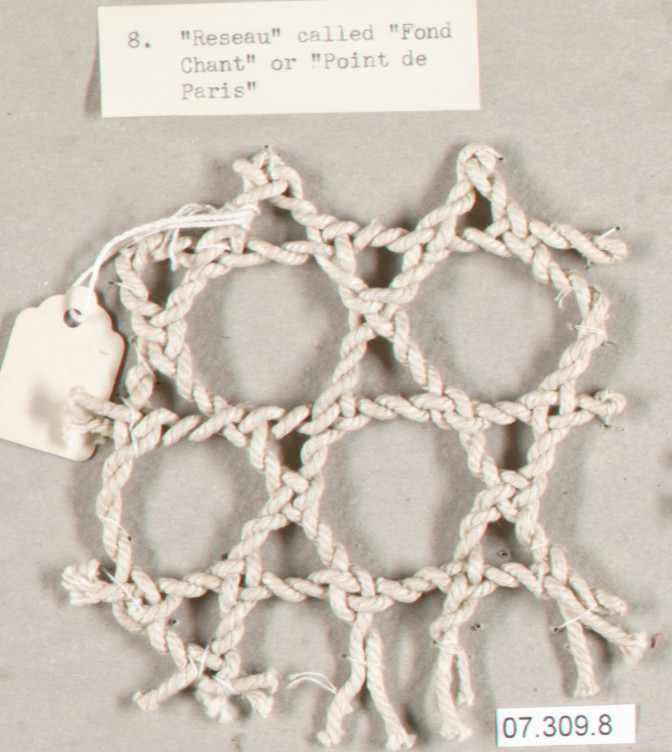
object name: stitch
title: Example of lace stitch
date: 1801-2000